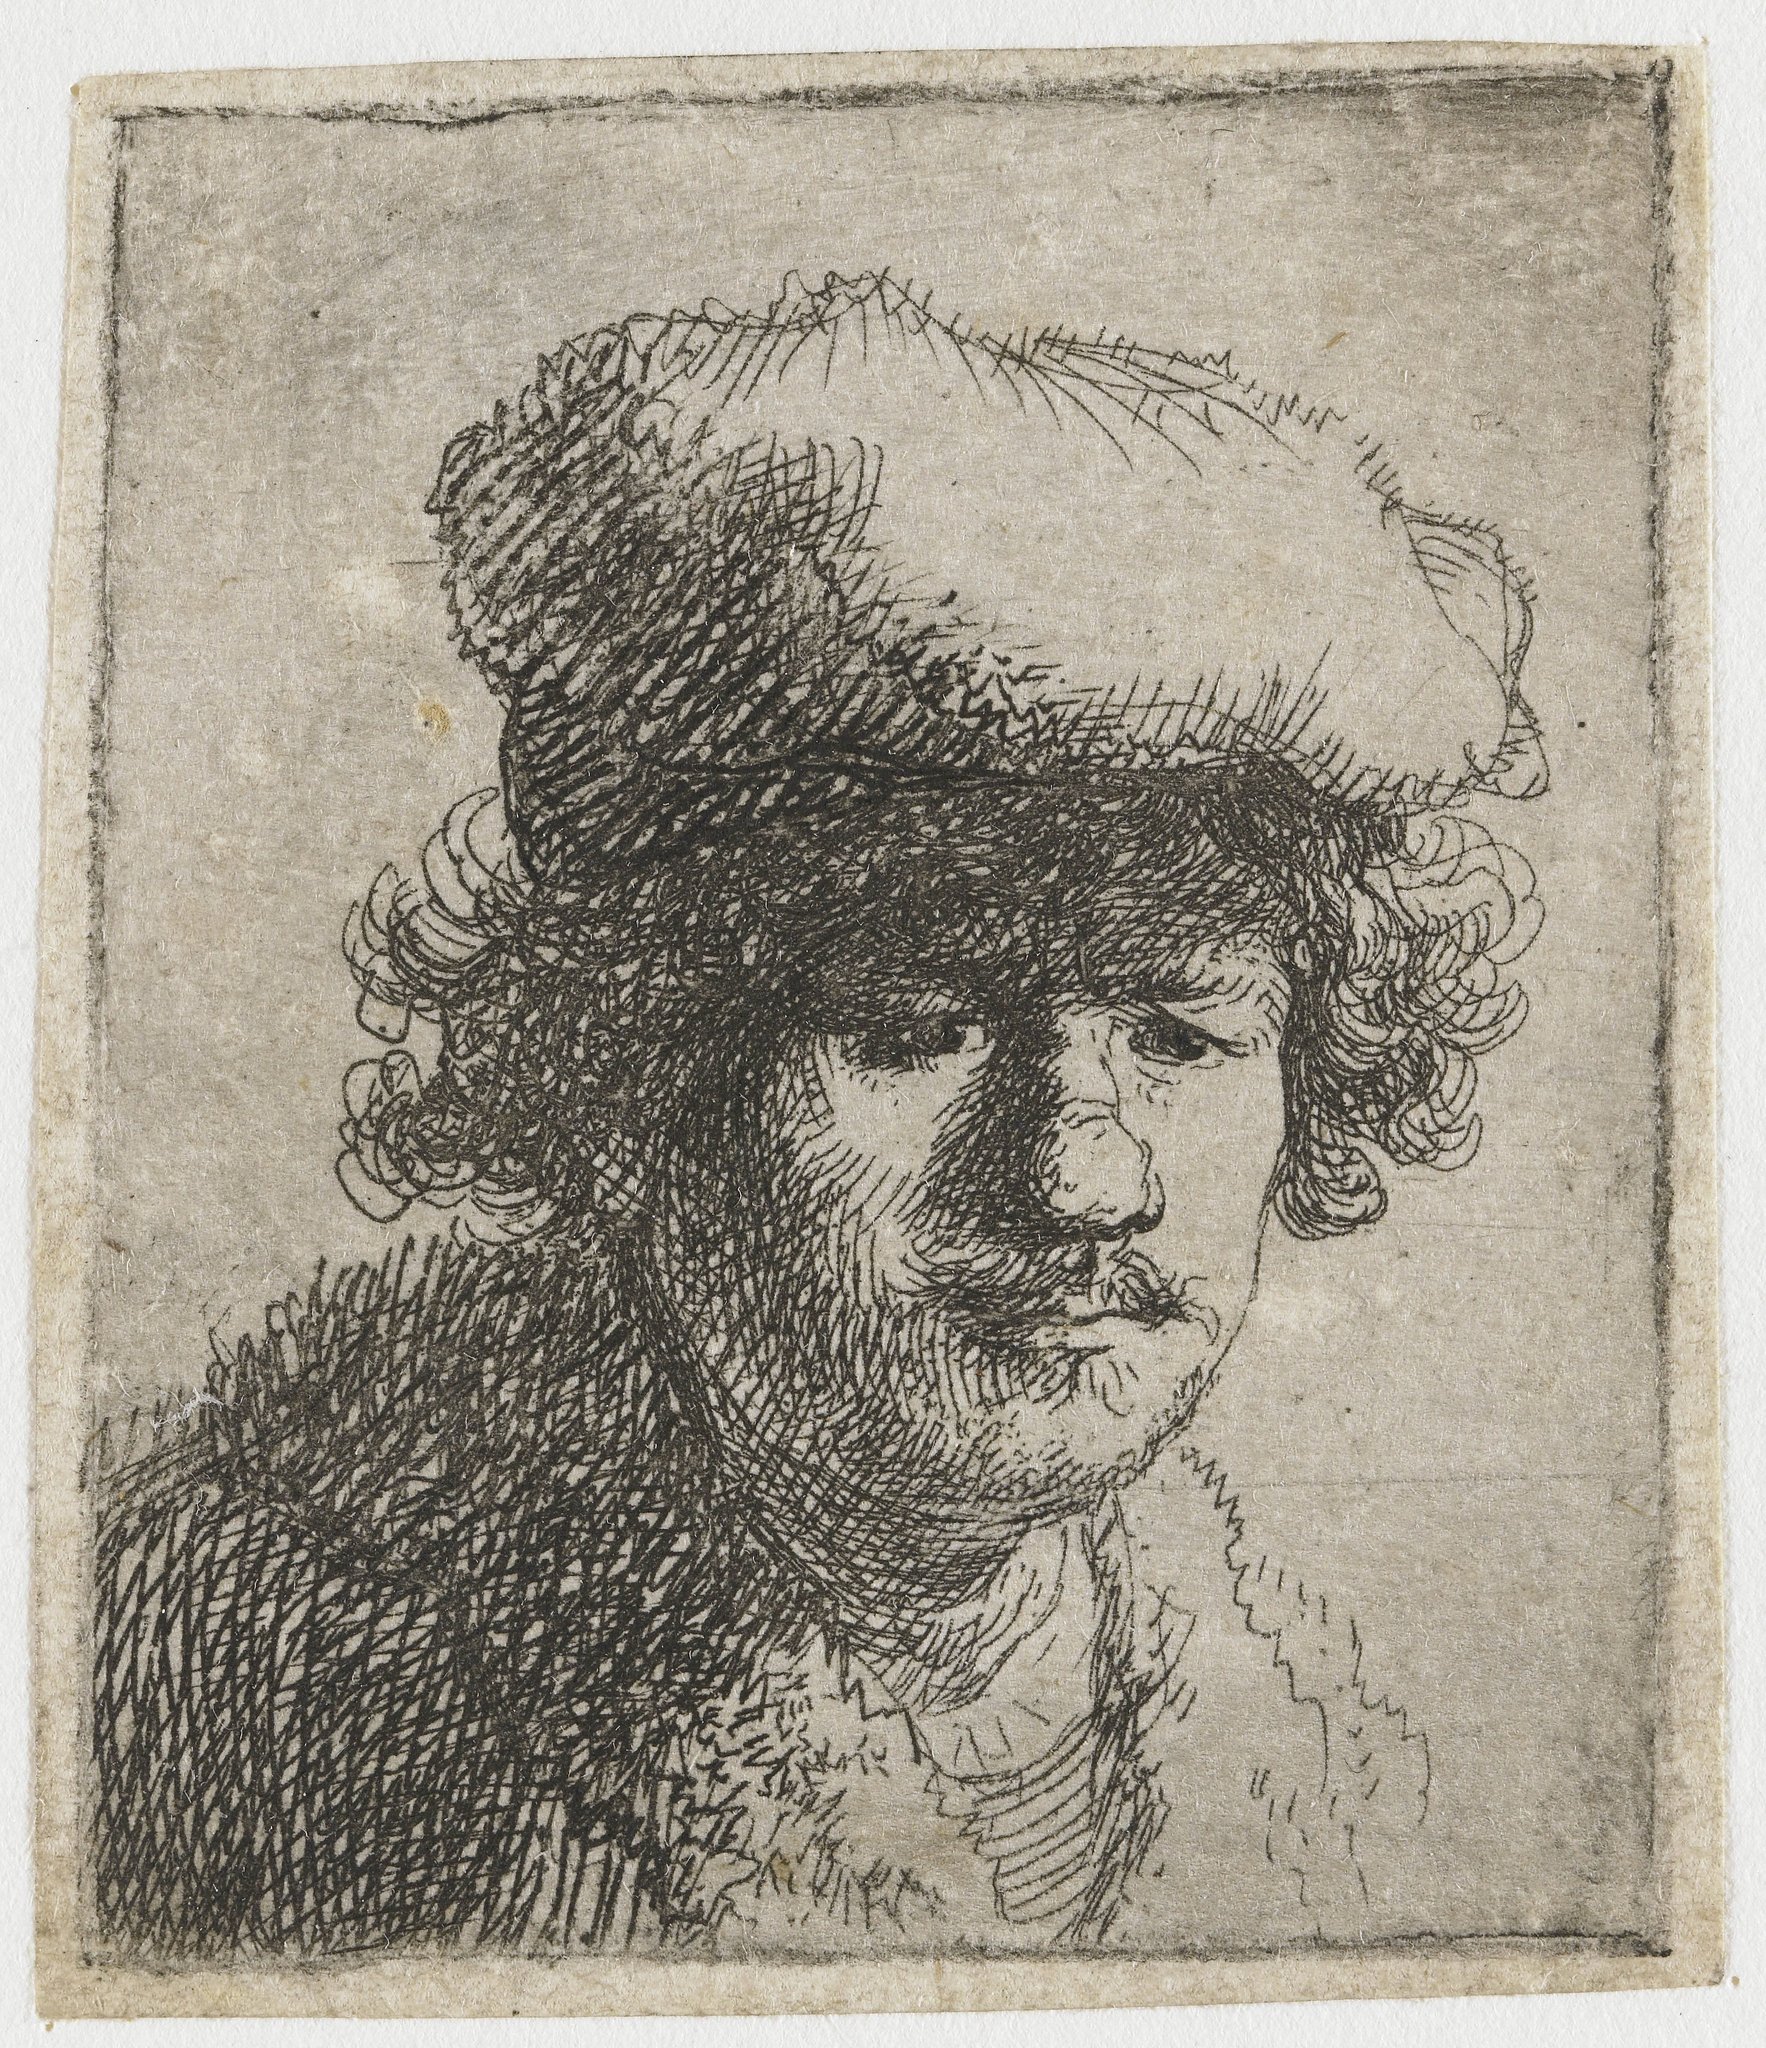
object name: print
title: Self-portrait with cap pulled forward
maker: rembrandt van rijn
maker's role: draughtsman, painter, print maker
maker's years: 1606-1669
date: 1630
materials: paper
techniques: etching, intaglio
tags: leiden, amsterdam, painter, print maker, draughtsman, rembrandt van rijn, head-gear: cap (+ men's clothes)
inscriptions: mark: Lugt 1119 b, mark: Lugt 2228